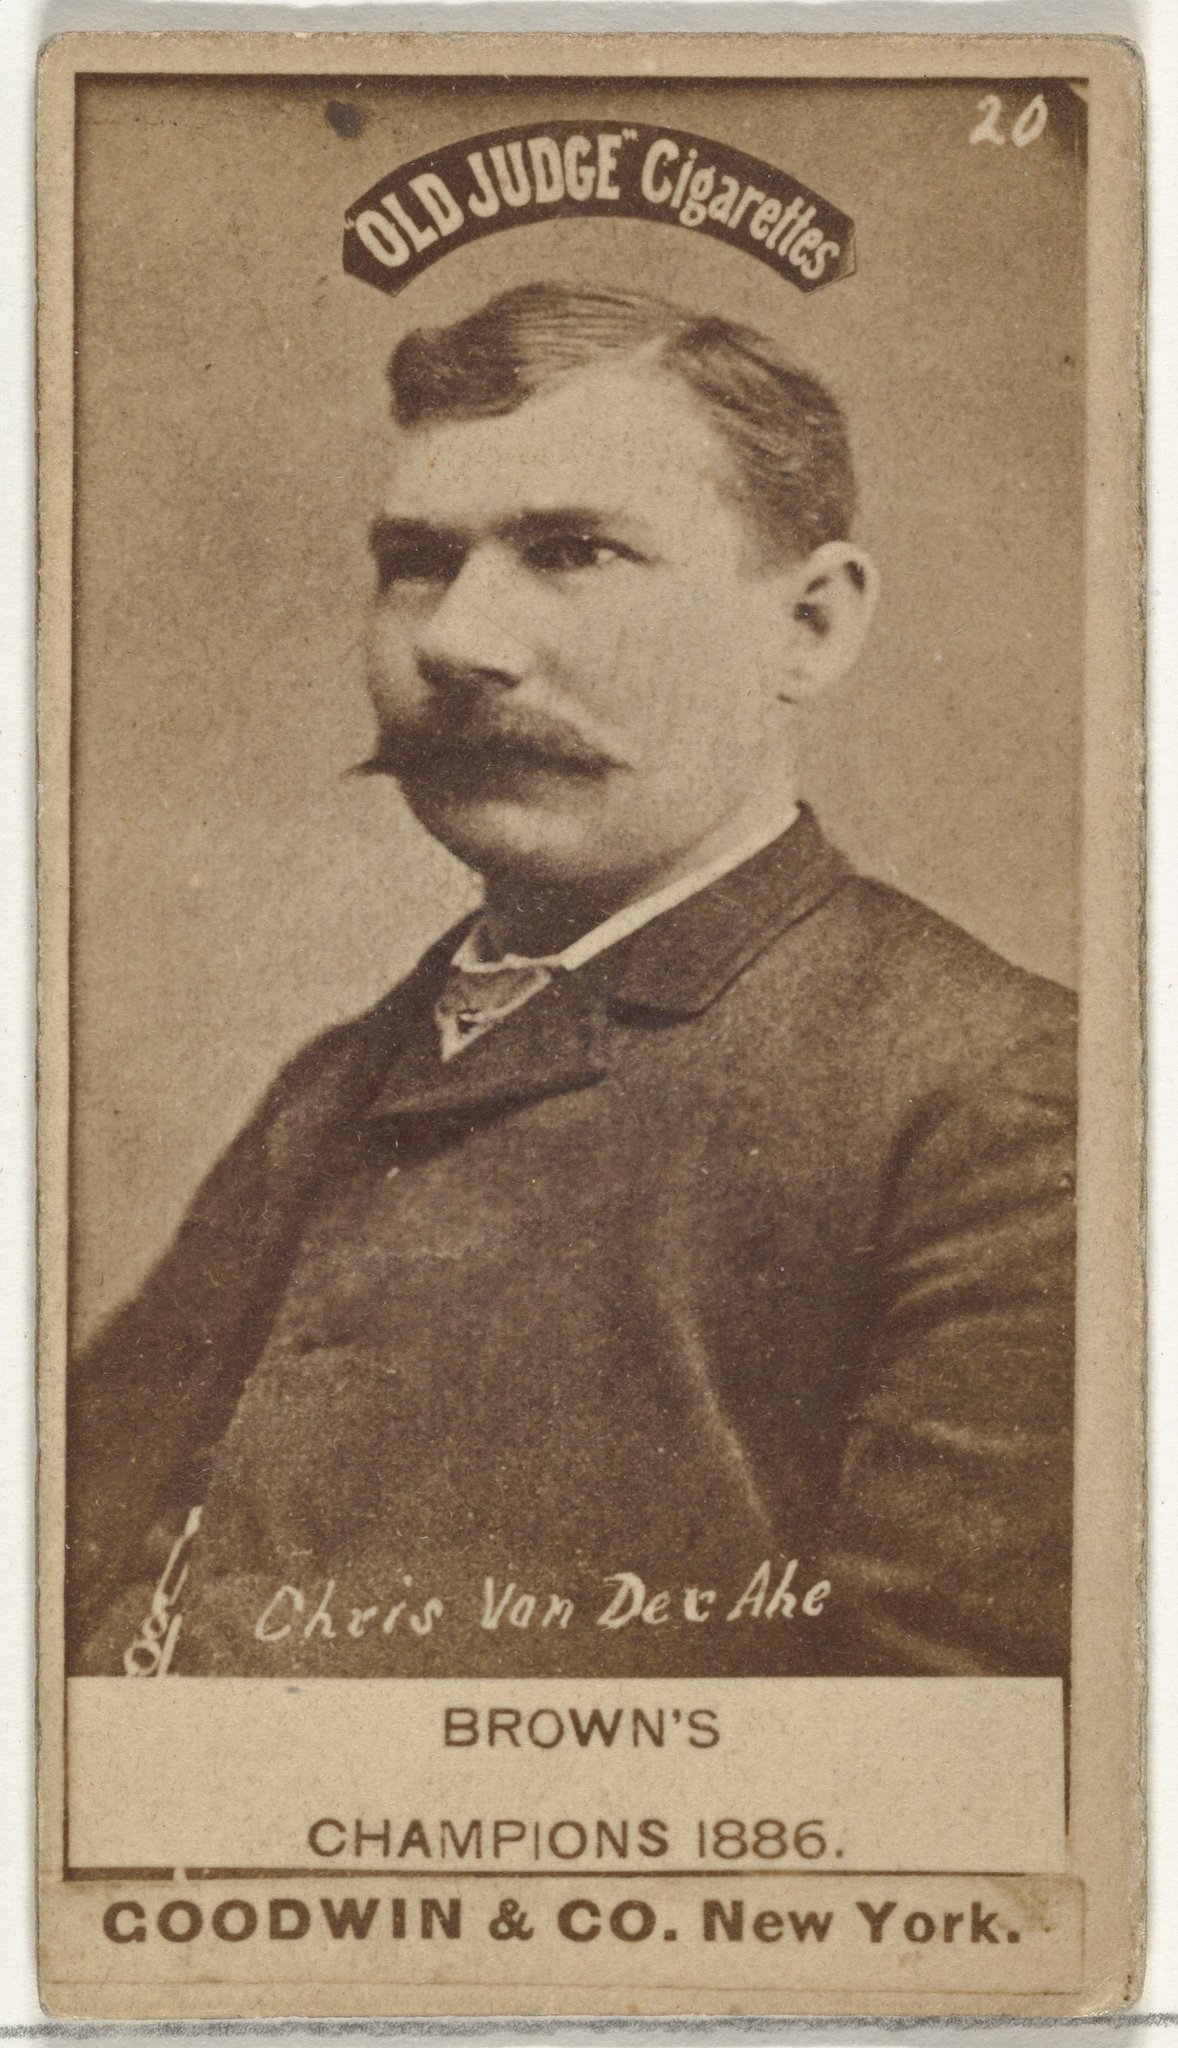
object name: baseball card, photograph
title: Chris Von der Ahe, St. Louis Browns, from the Old Judge series (N172) for Old Judge Cigarettes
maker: goodwin & company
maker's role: publisher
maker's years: 1850-1950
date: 1886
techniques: albumen silver print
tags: men,portraits